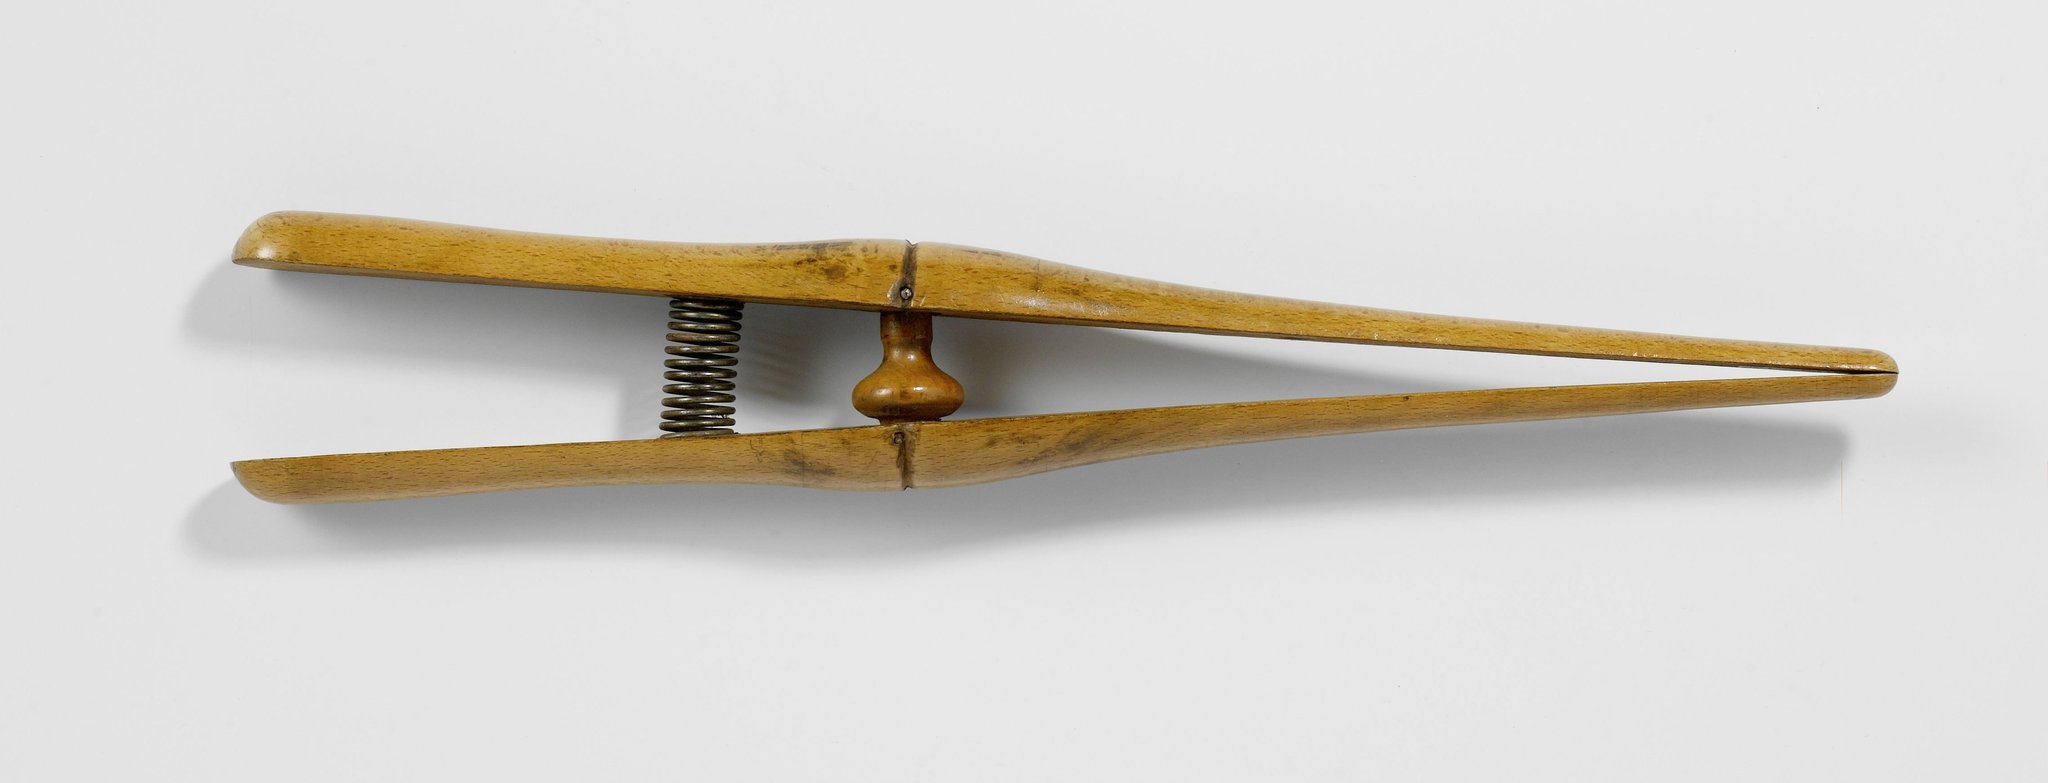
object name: glove stretcher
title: Handschoenrekker van gelakt hout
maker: Anonymous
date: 1885-1950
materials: lacquer, metal, wood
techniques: cutting, lacquer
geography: netherlands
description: Handschoenrekker van gelakt hout, met tussen de twee scharen een metalen veer.